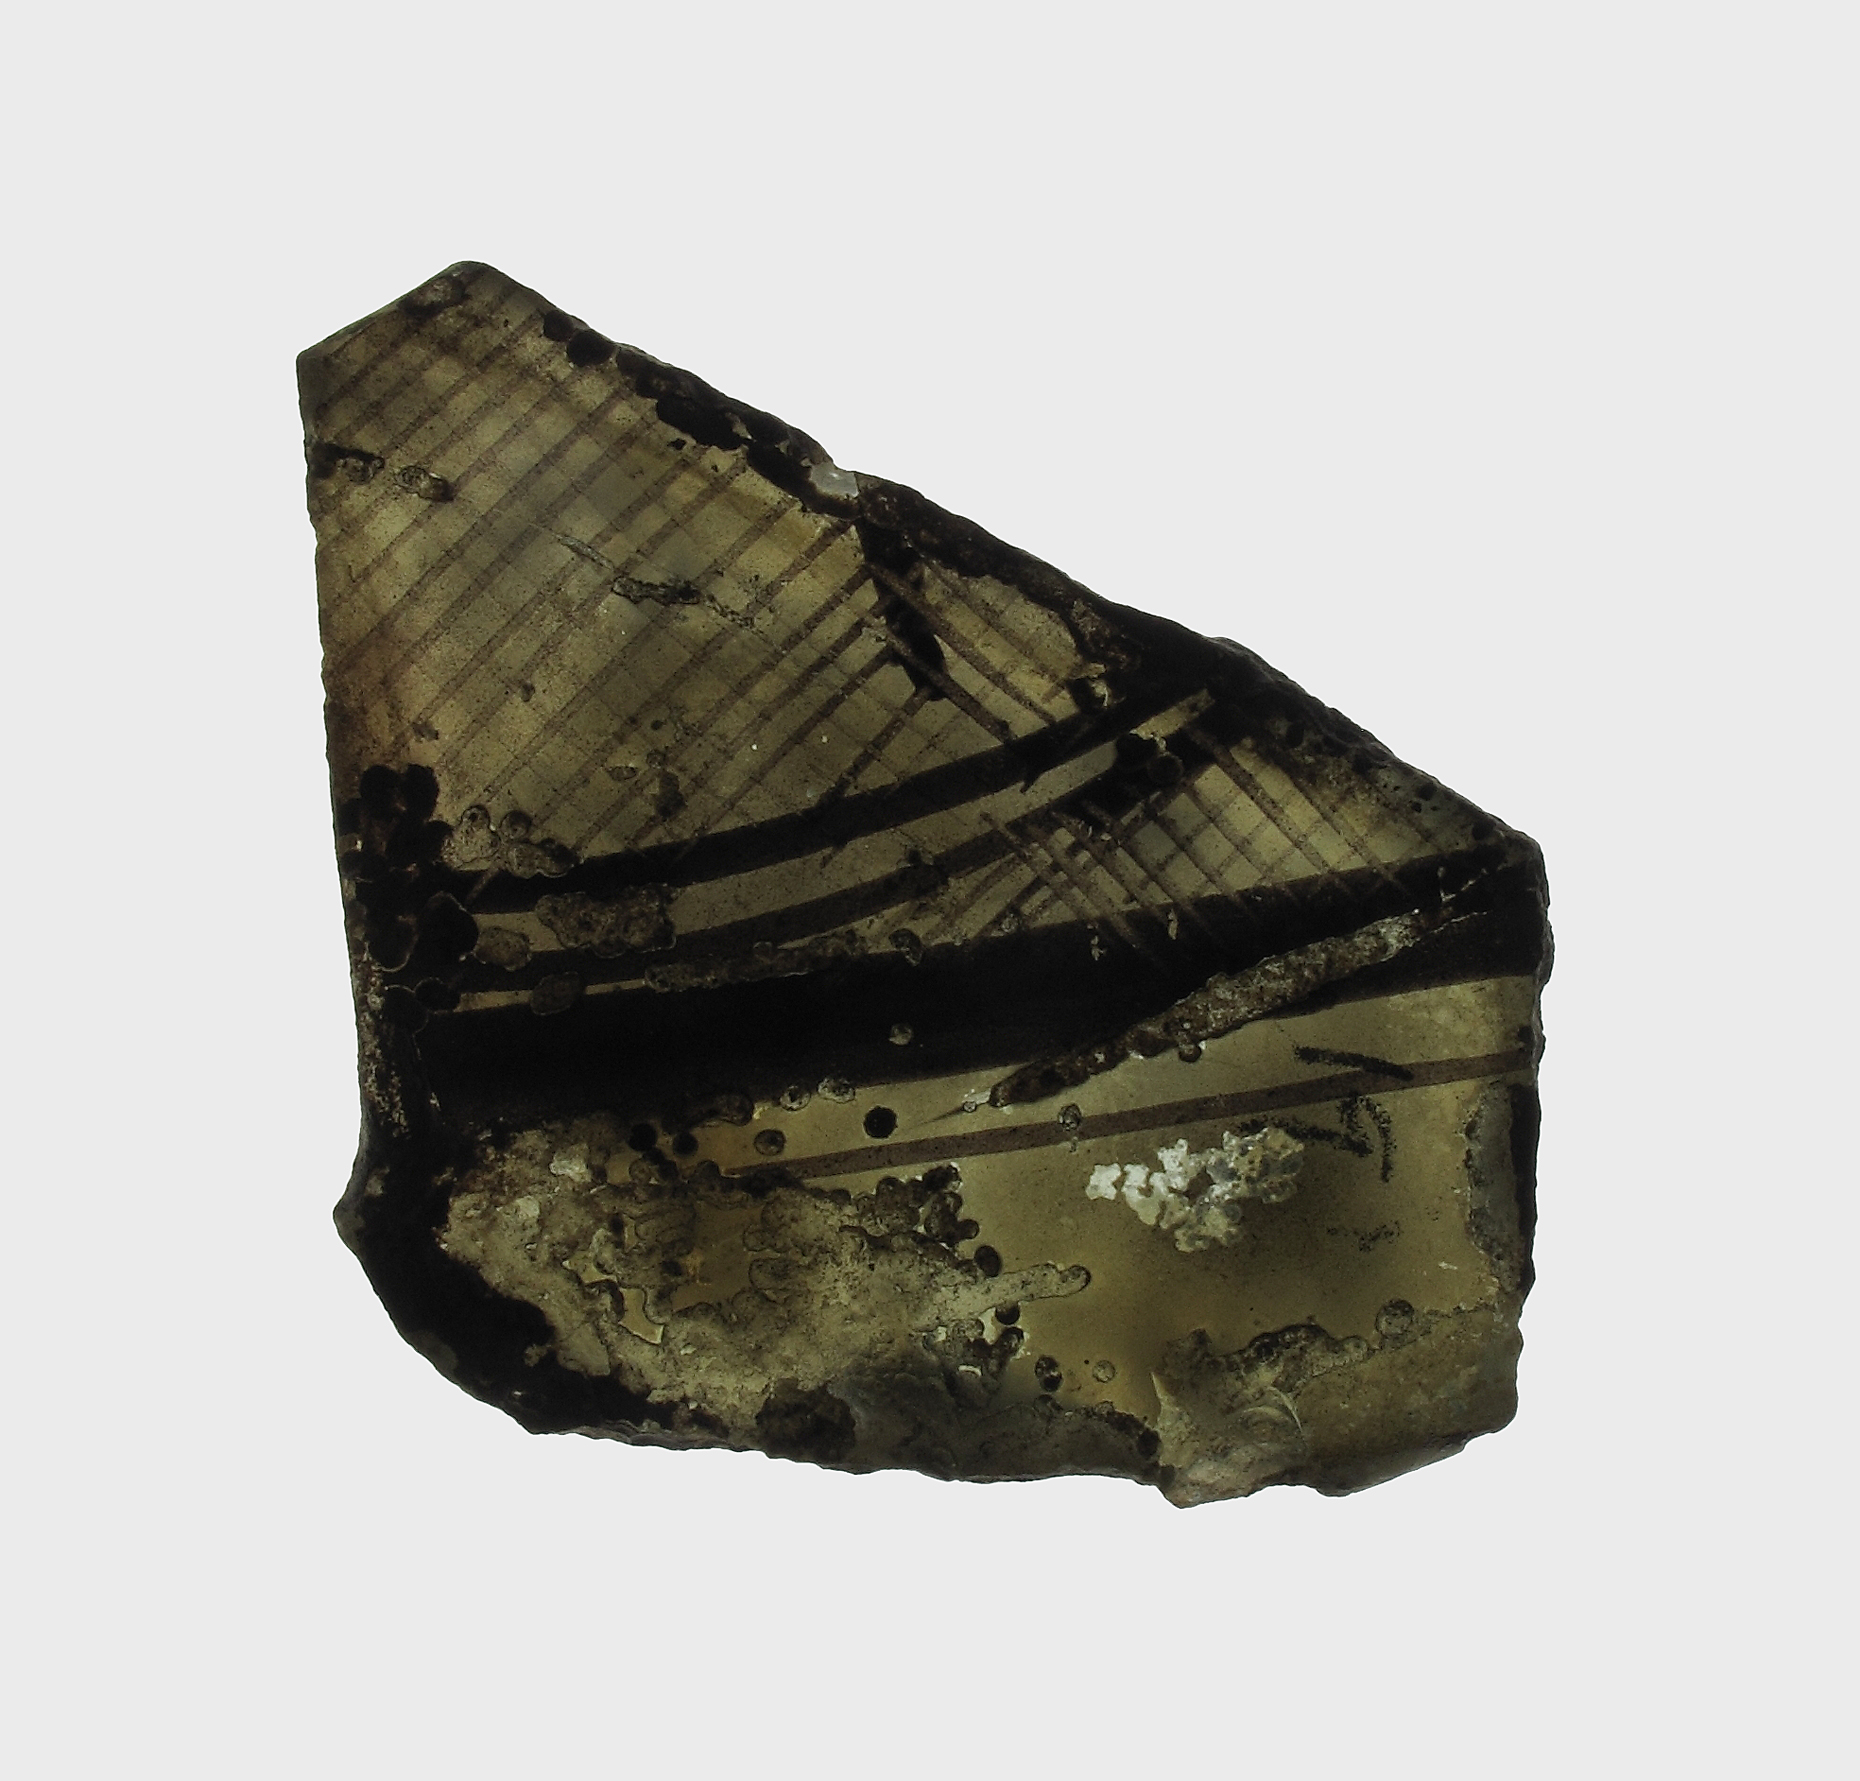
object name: fragment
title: Glass Fragment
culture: british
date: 1201-1300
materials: glass